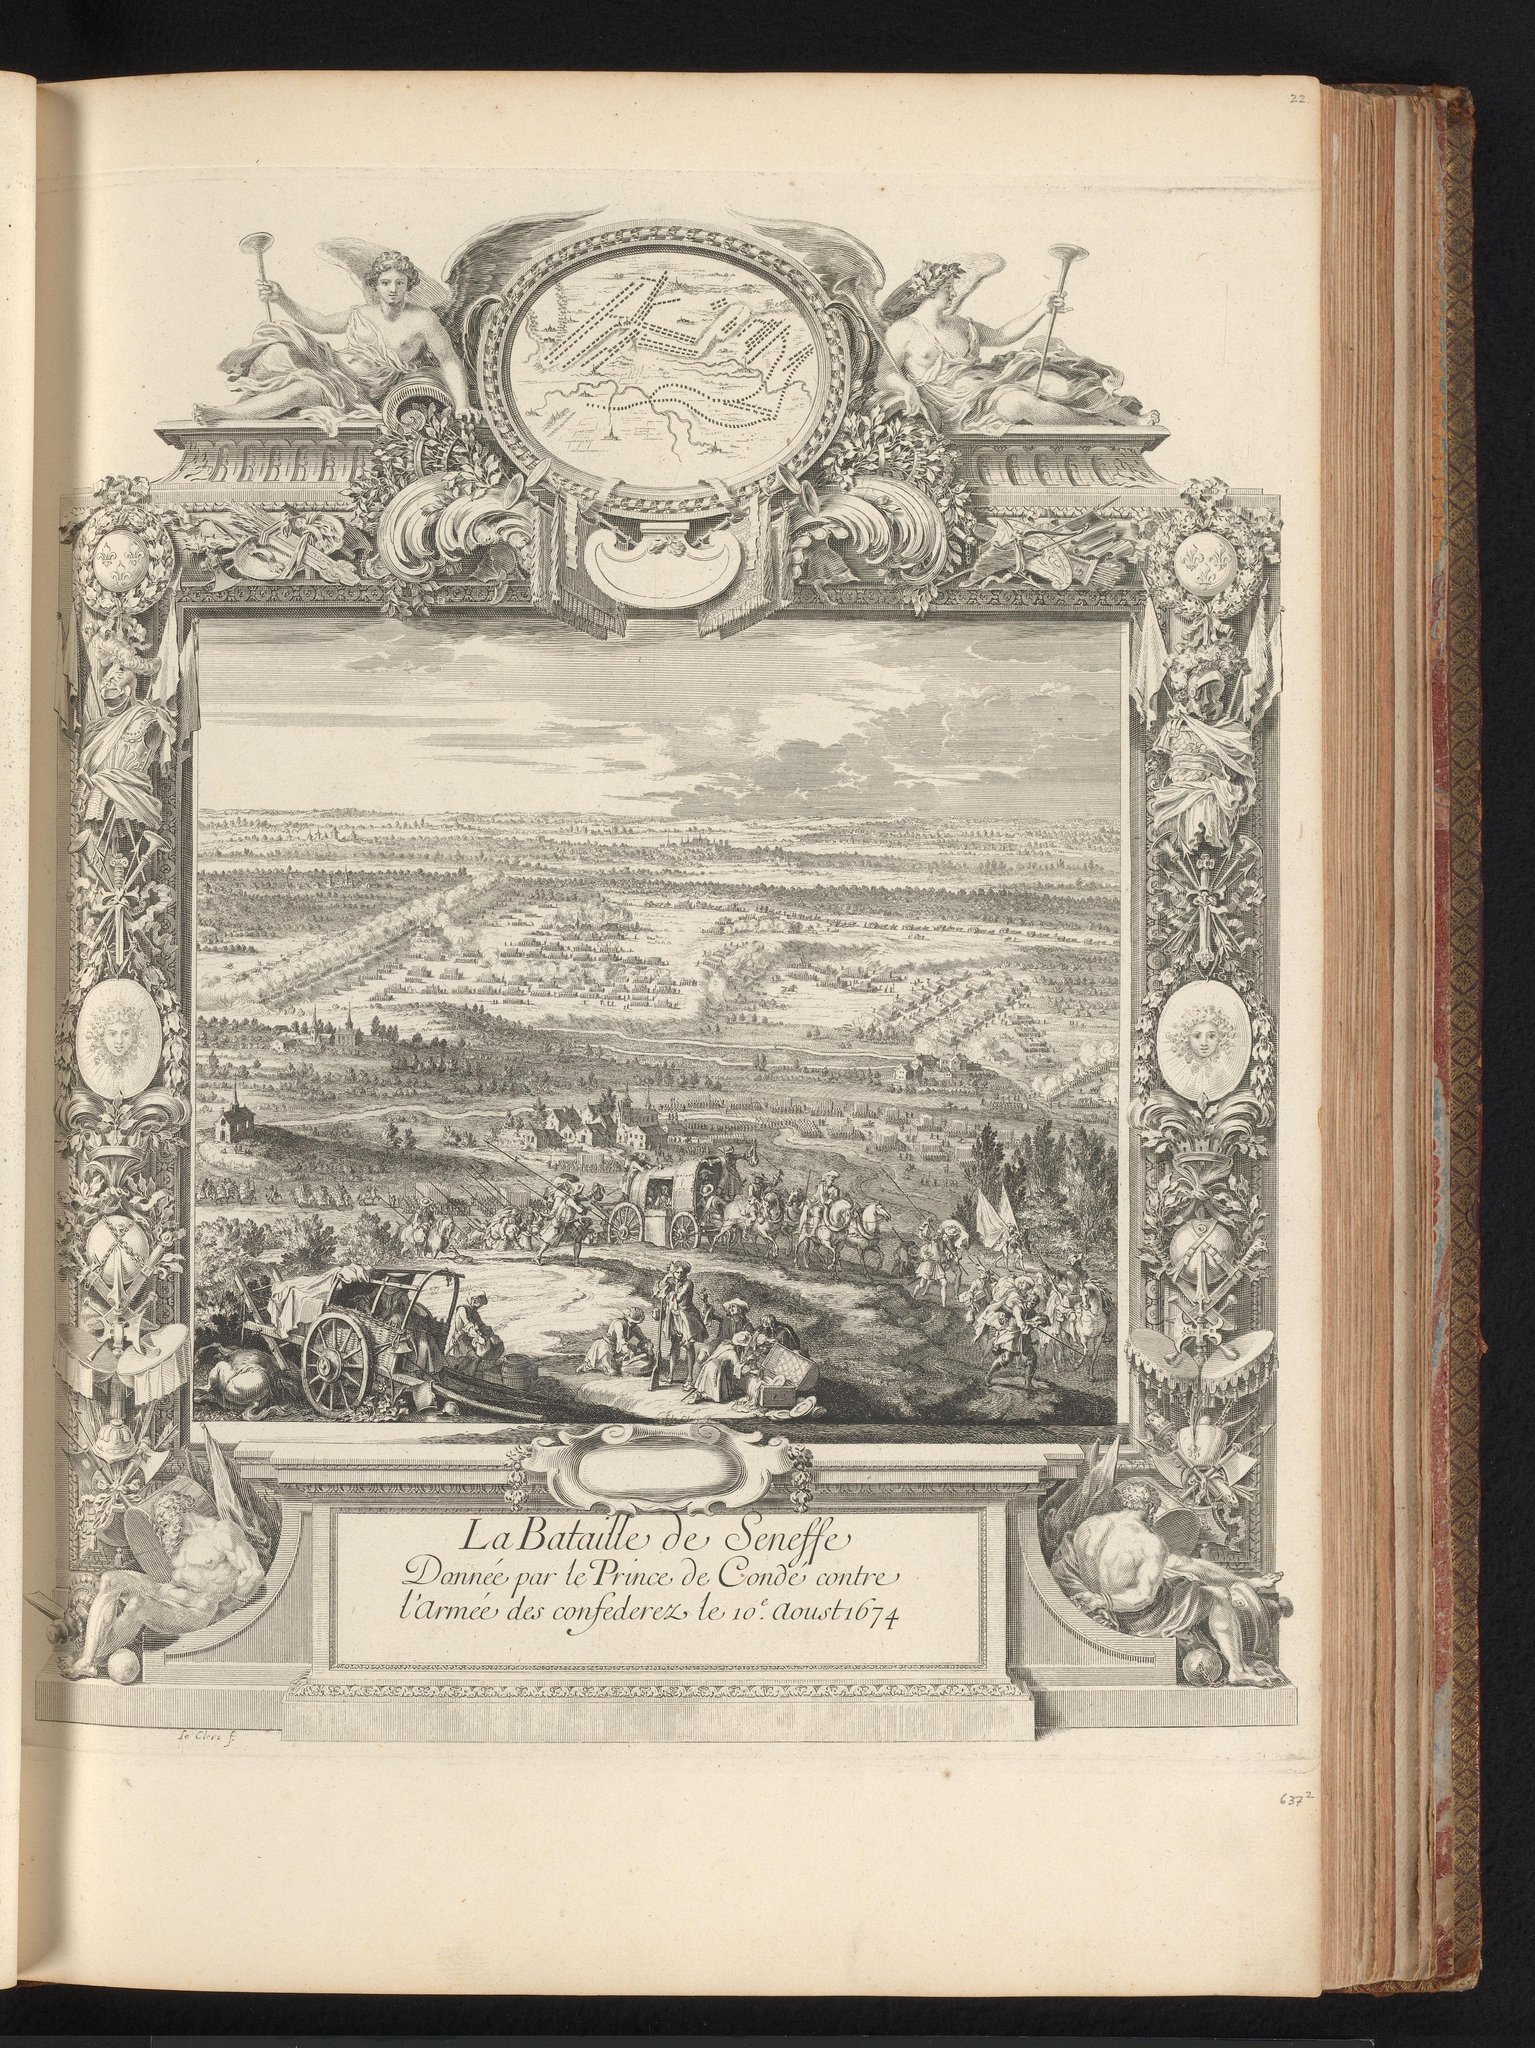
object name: album leaf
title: Slag bij Seneffe, in een cartouche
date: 1686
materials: paper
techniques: engraving, etching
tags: paris, lodewijk ii de bourbon-condé (hertog van enghien), historical persons, battle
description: Maakt deel uit van een serie bestaande uit 28 prenten met oorlogstaferelen in ornamentele cartouches. De prenten zijn gedrukt van twee afzonderlijke platen bestaande uit de voorstelling en de cartouche.